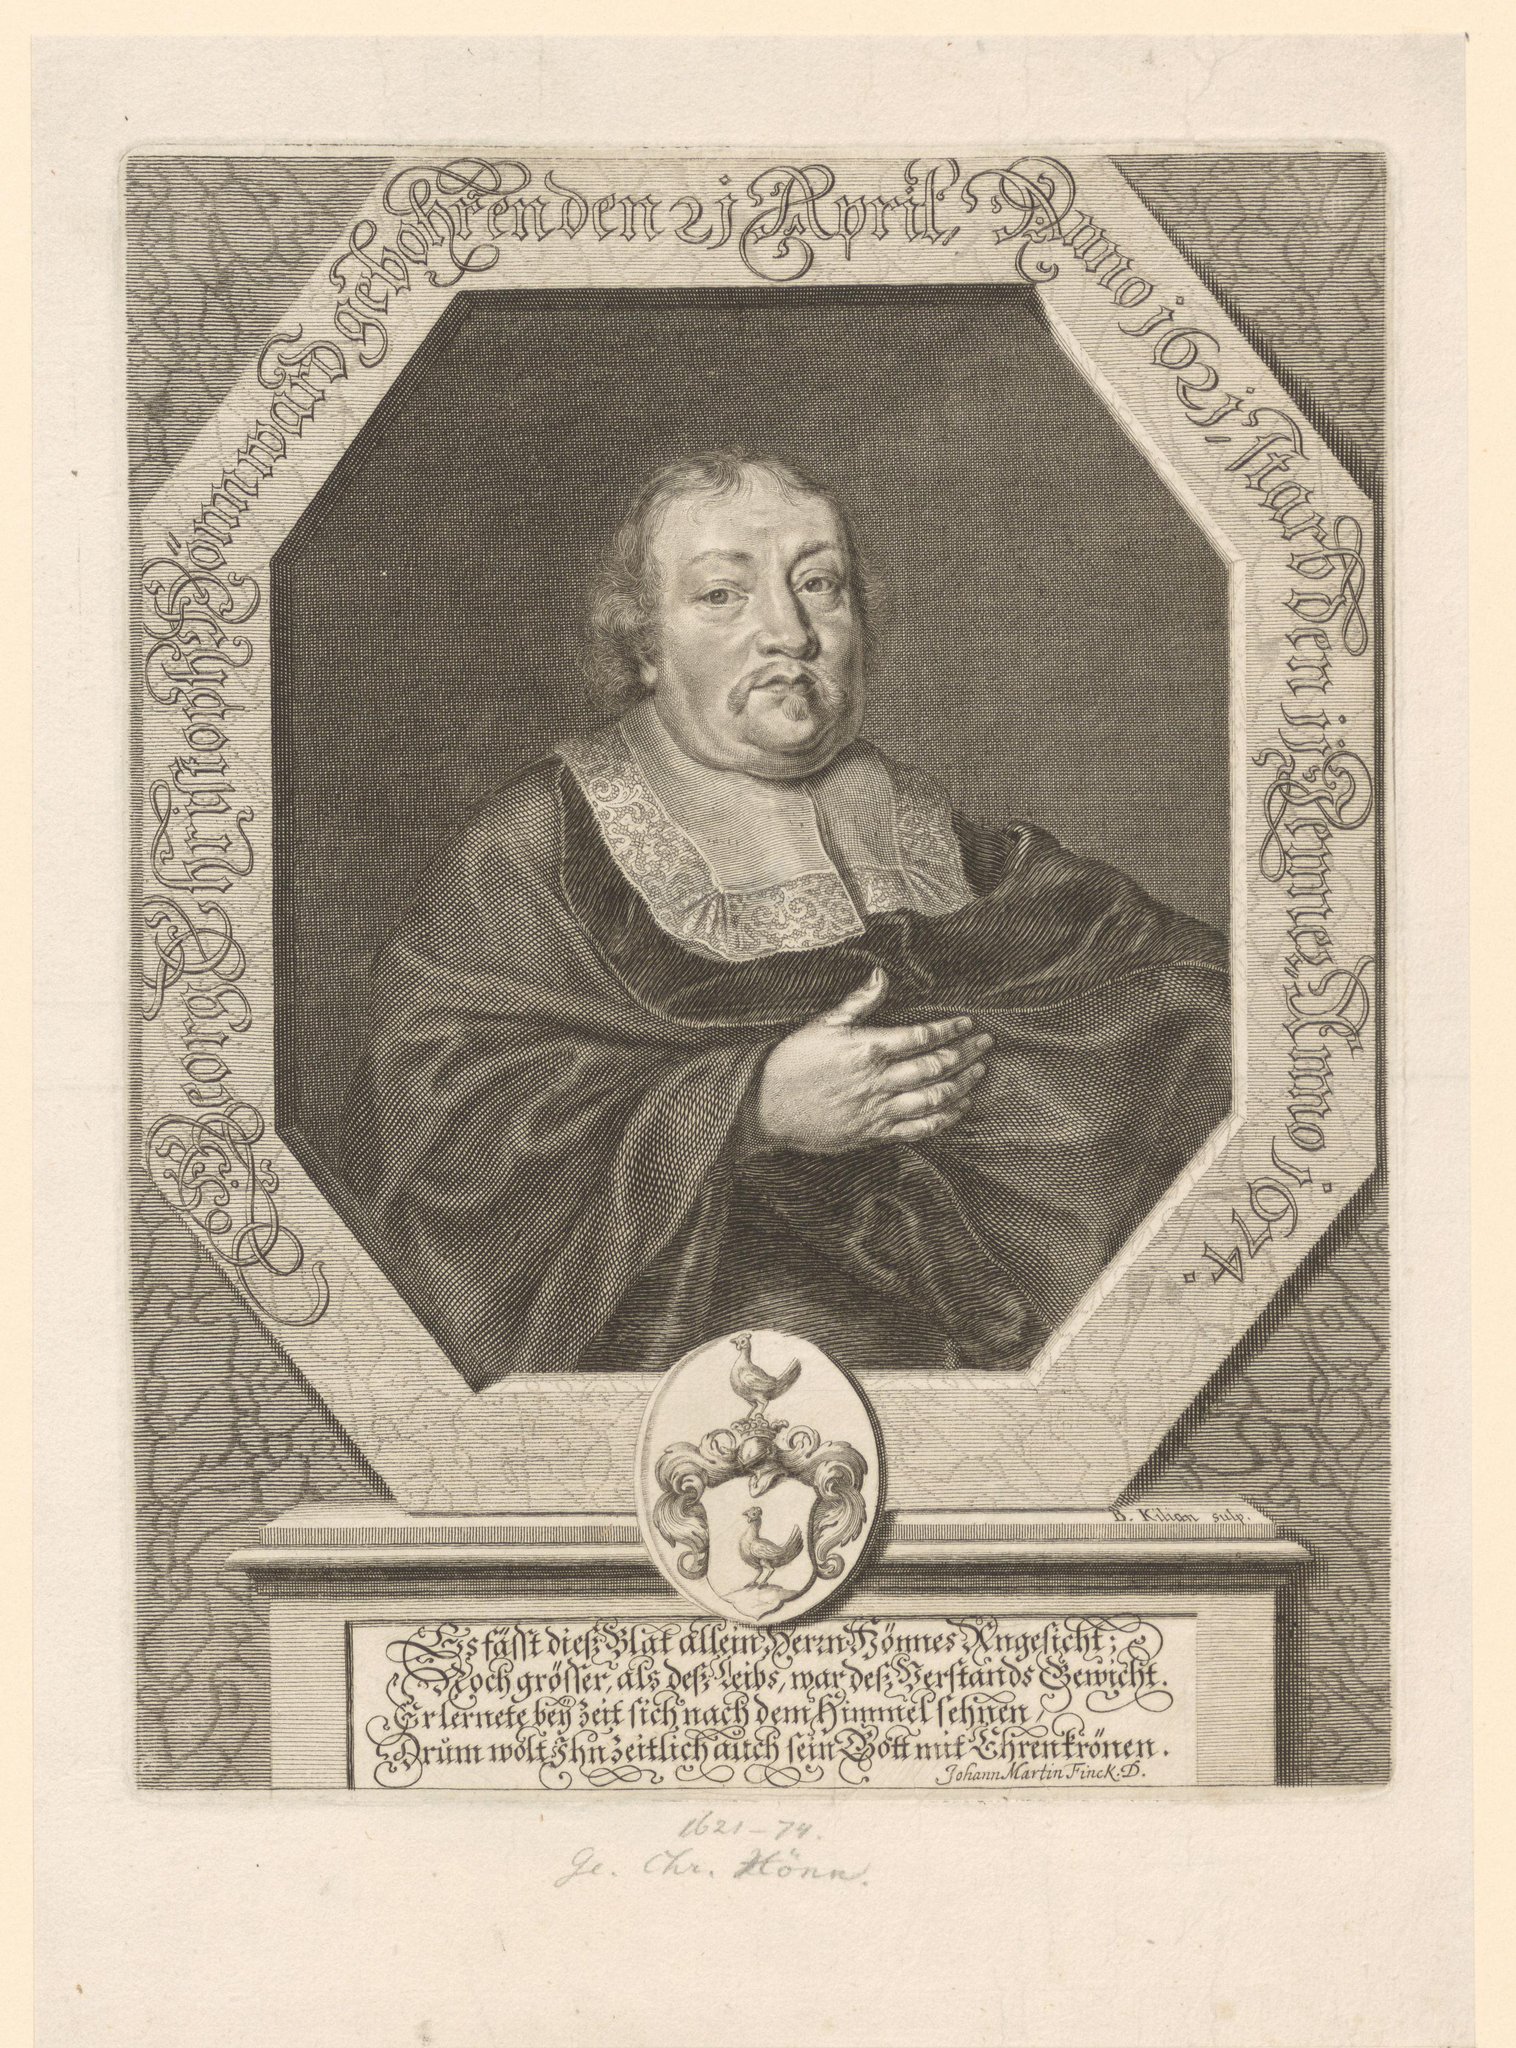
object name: print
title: Portret van Georg Christoph Hön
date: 1674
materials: paper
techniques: engraving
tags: historical persons, merchant, salesman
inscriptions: collector's mark: Lugt 2228